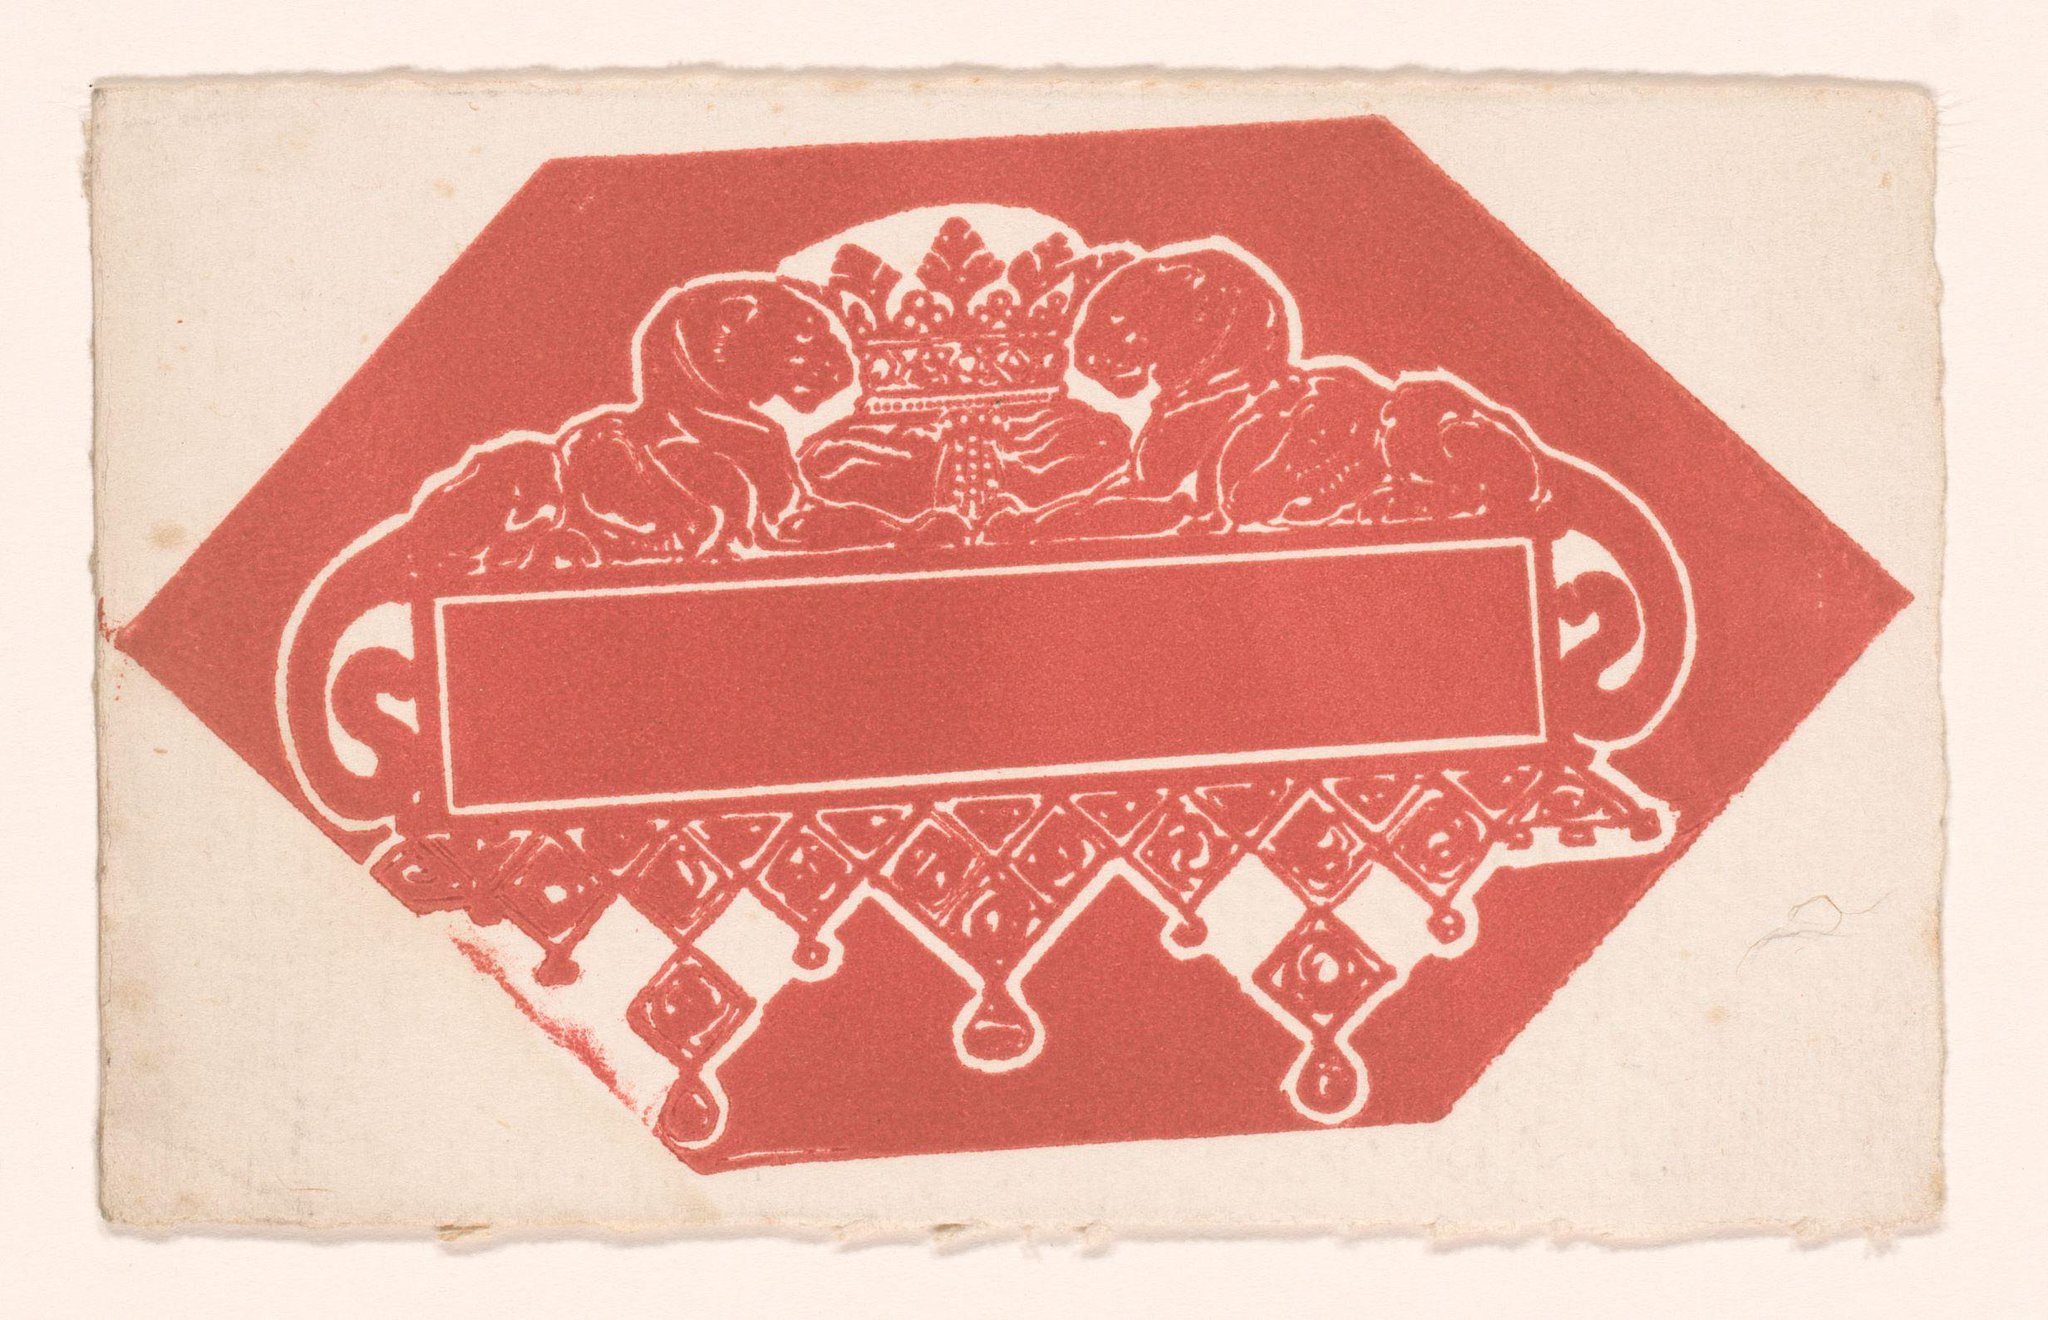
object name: print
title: Titelvignet met twee leeuwinnen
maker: bernard willem wierink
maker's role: draughtsman, print maker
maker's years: 1856-1939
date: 1910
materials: paper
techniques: relief print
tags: beasts of prey, predatory animals: lion (+ female animal), fable of reynard the fox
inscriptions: collector's mark: Lugt 2228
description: Ontwerp voor: Streuvels, Stijn (Frank Lateur). Reinaert de Vos naar verschillende uitgaven van het middeleeuwsche epos. Amsterdam: L.J. Veen, 1910. Deze prent is vermoedelijk een plaatsnede, ook al wordt in de literatuur veelal gesproken over een houtsnede. Voor zover Wierink zijn prenten in hoogdruk zelf nader heeft omschreven, heeft hij altijd de term 'plaatsnede' gebruikt.